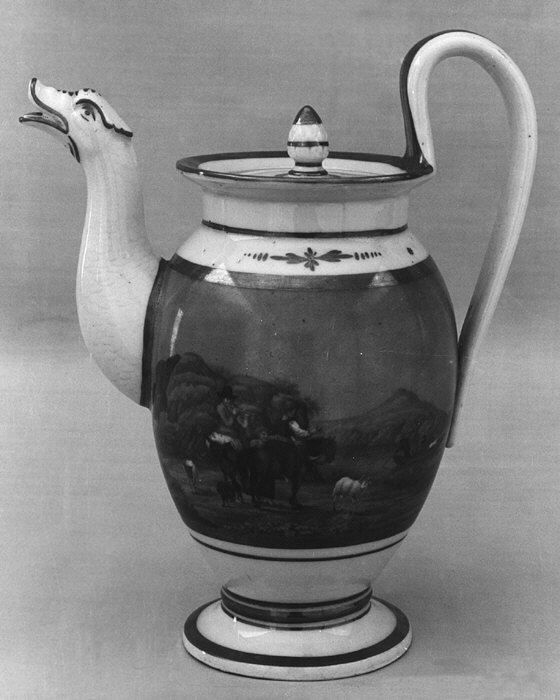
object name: coffeepot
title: Coffeepot (part of a set)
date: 1820-1830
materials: hard paste porcelain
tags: birds,men,horses,rams